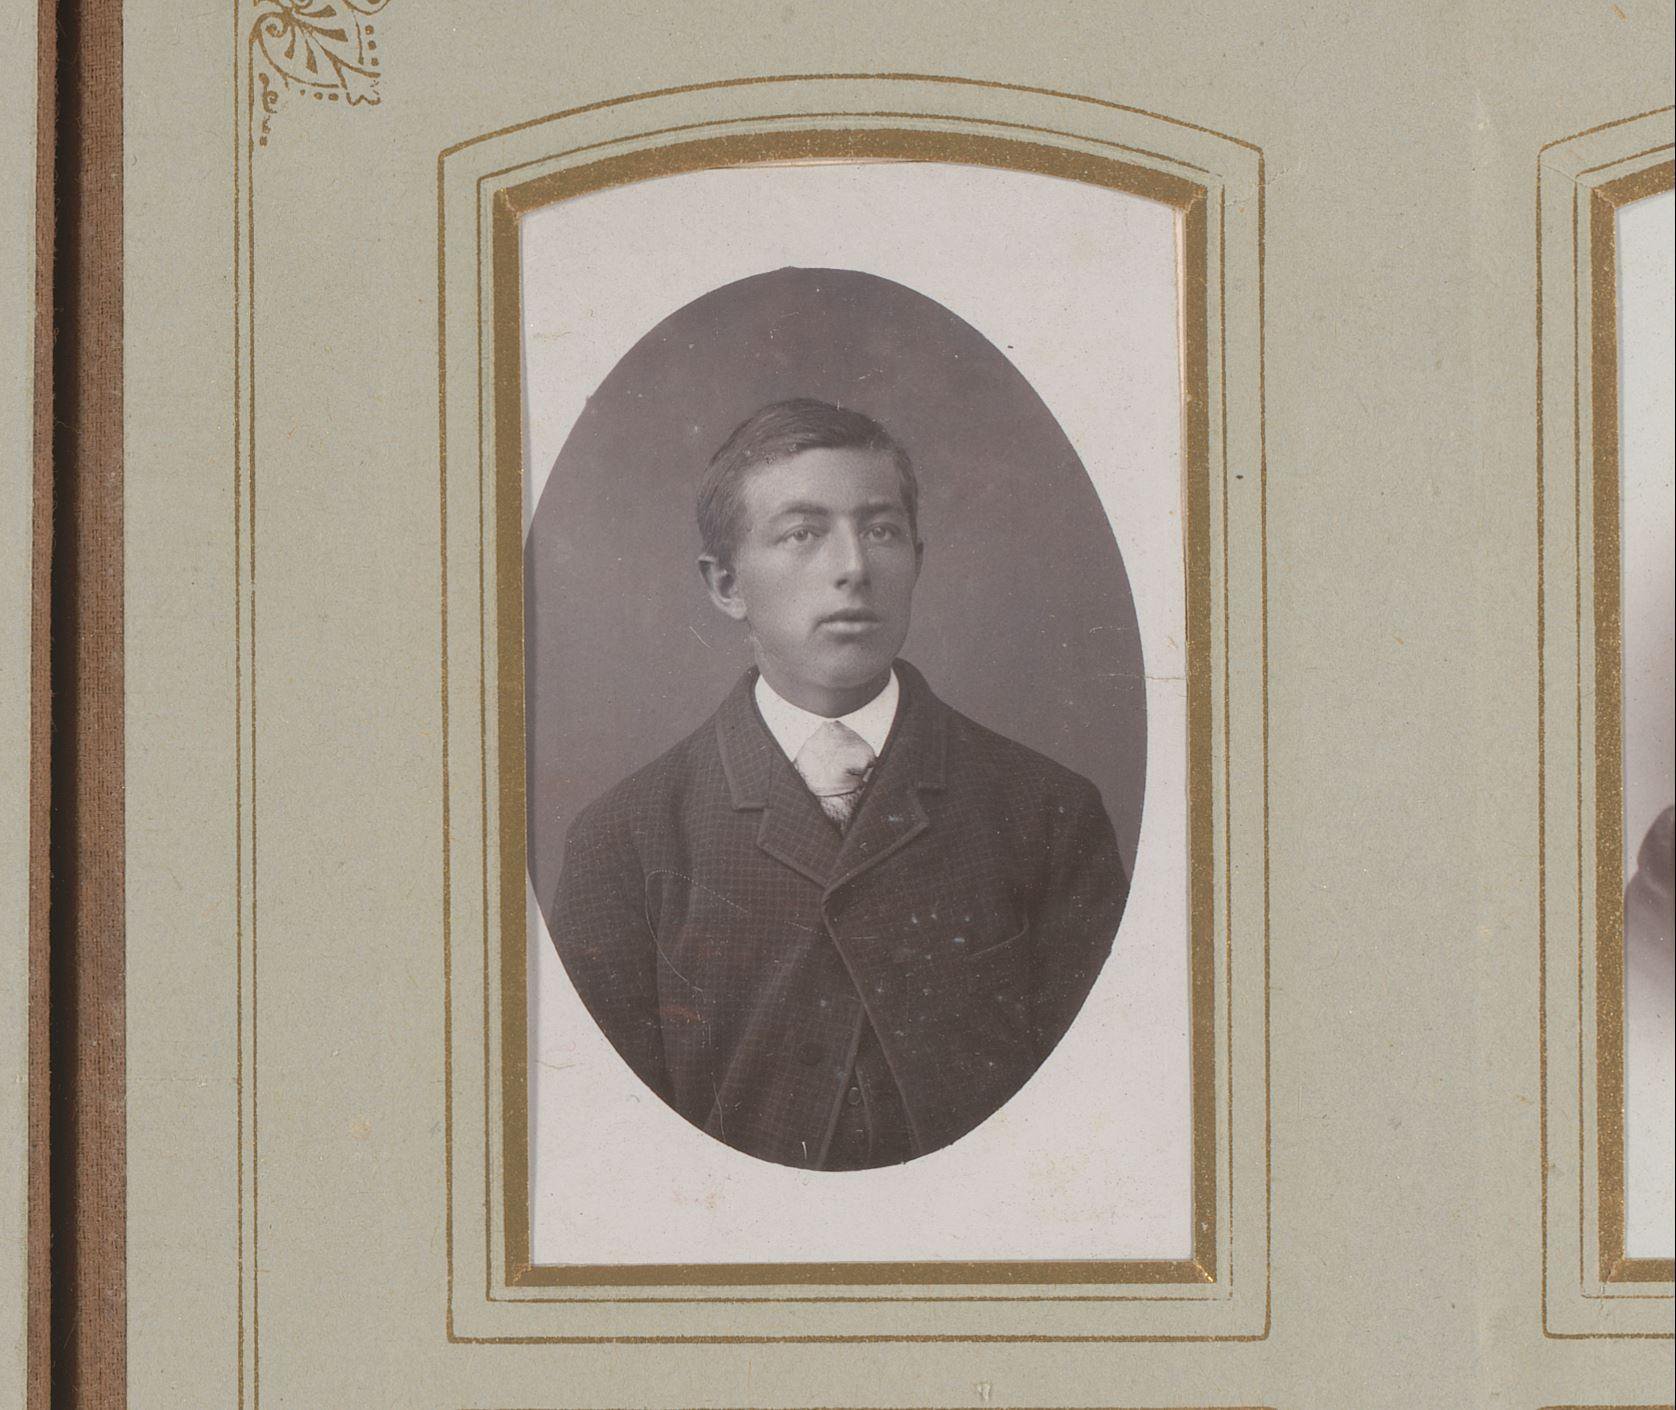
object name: photograph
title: Portret van een jonge man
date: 1865-1874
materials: cardboard, photographic support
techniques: collodion silver print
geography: wormerveer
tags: historical persons, youth, adolescent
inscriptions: inscription: ‘Gebrs IJPMA./ FOTOGRAFEN./ EDAM/ VOORHAVEN./ WORMERVEER/ WANDELWEG’